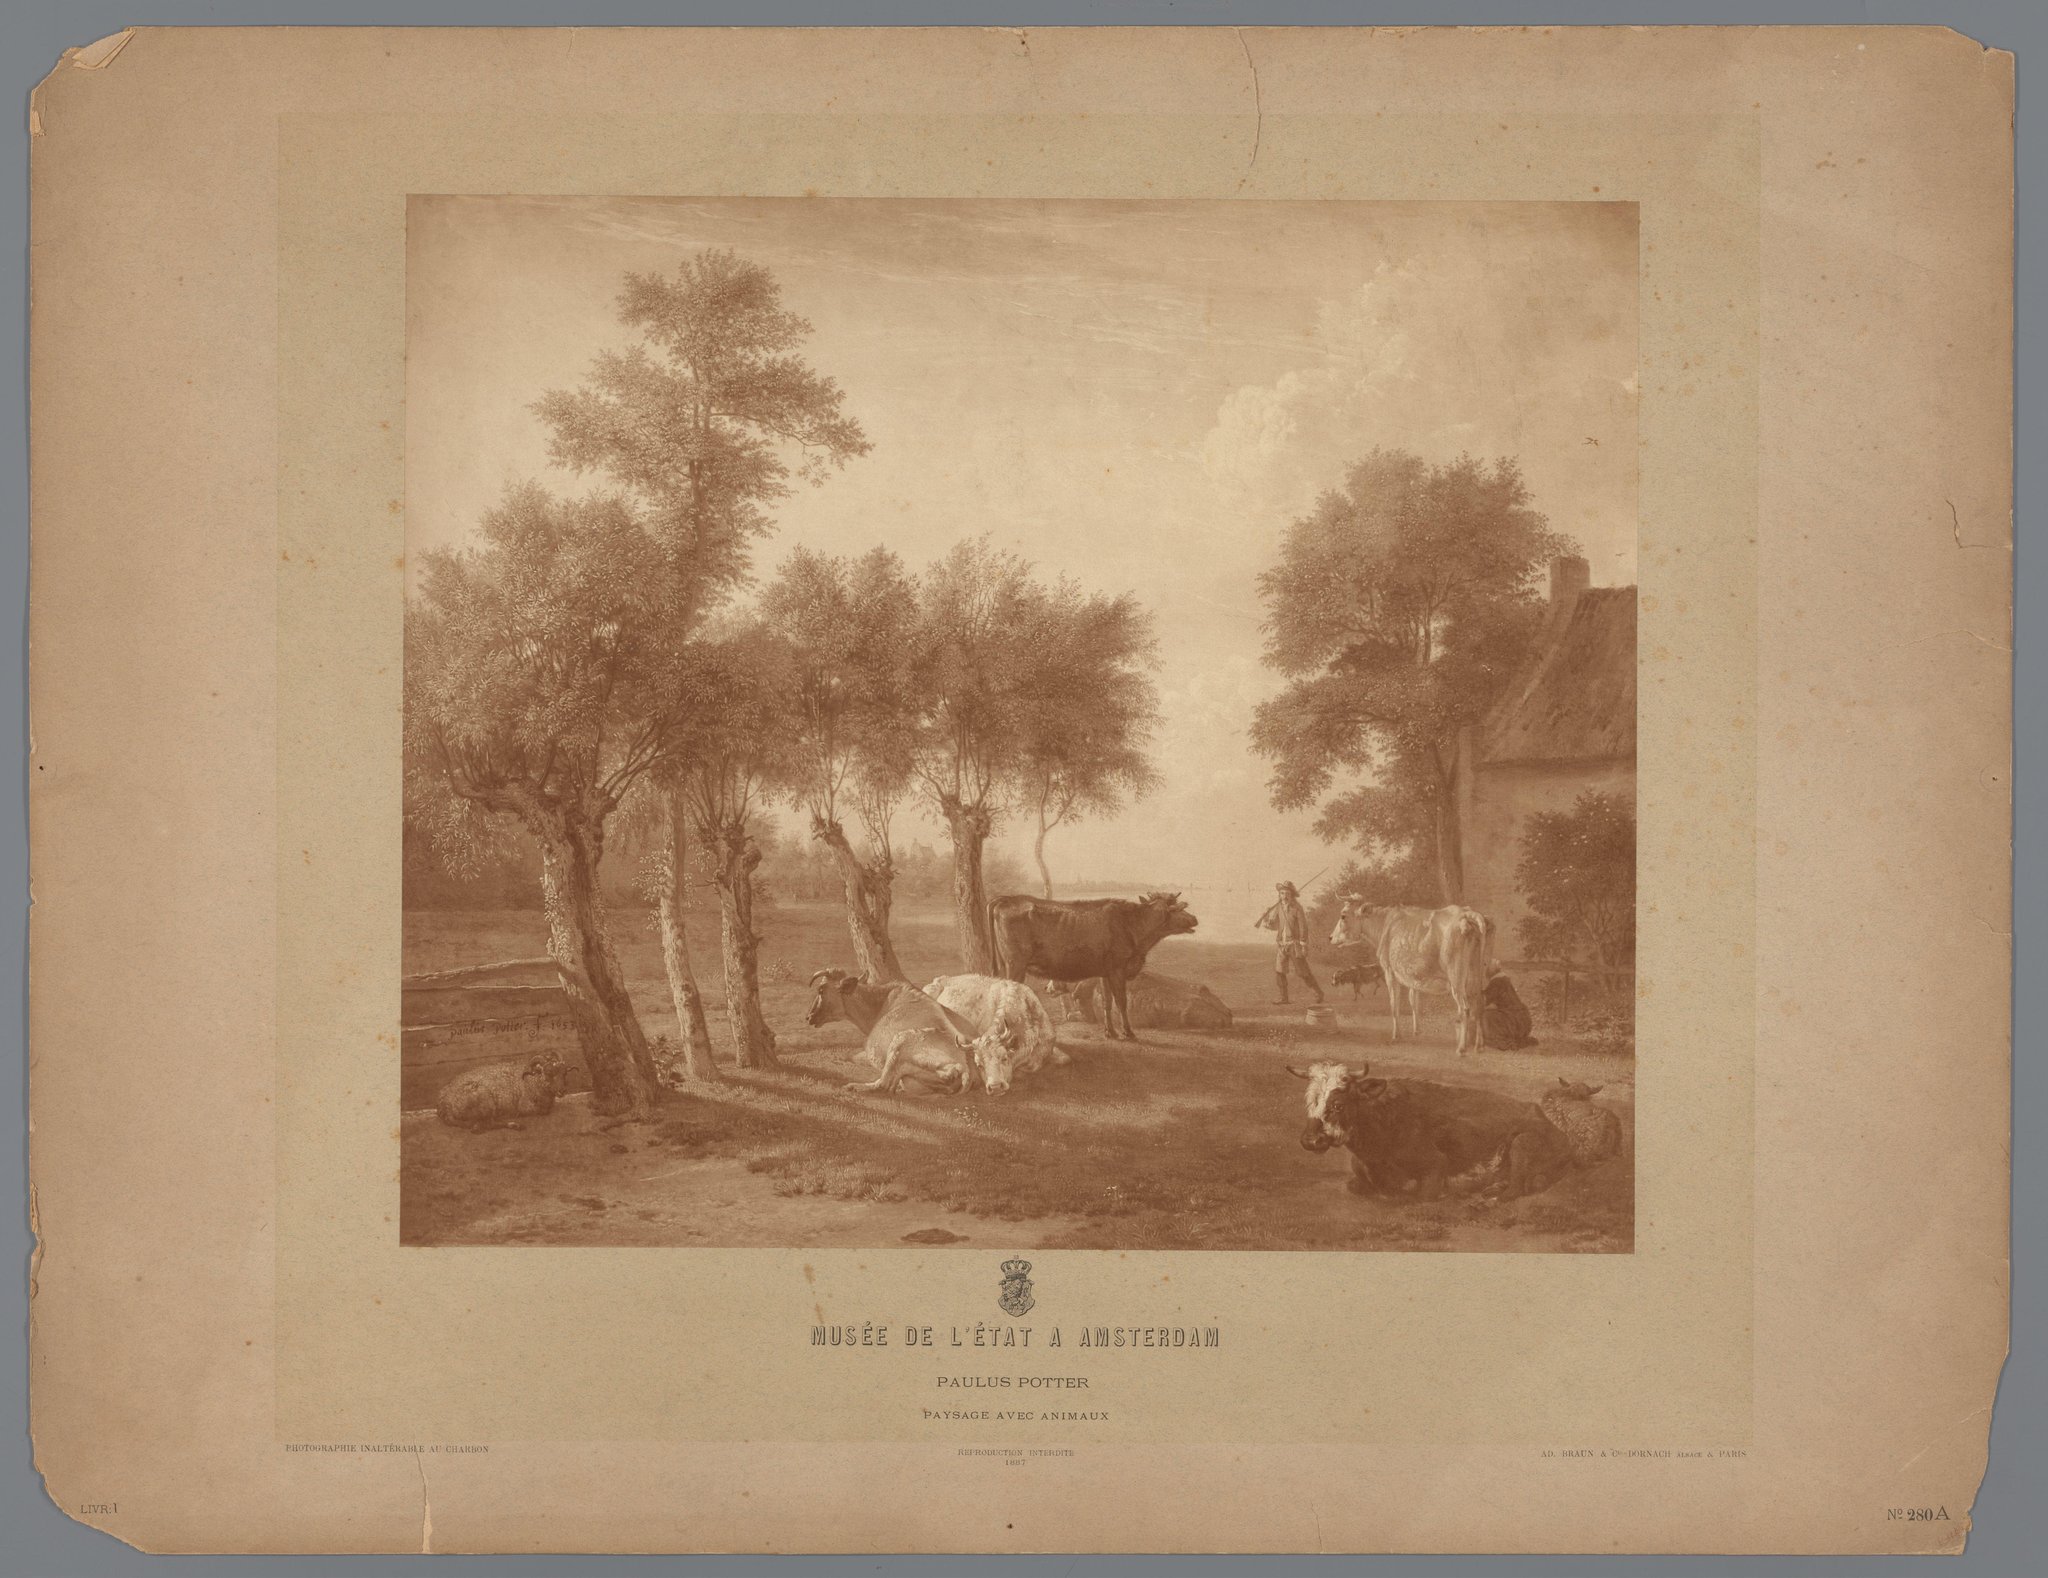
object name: photograph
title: Fotoreproductie van een schilderij van Paulus Potter, 'Koeien in de weide bij een boerderij' (coll. Rijksmuseum)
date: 1887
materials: cardboard, paper, photographic support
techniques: carbon print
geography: netherlands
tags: farm or solitary house in landscape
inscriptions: annotation: ‘F. 10 / A / 30/3 08’